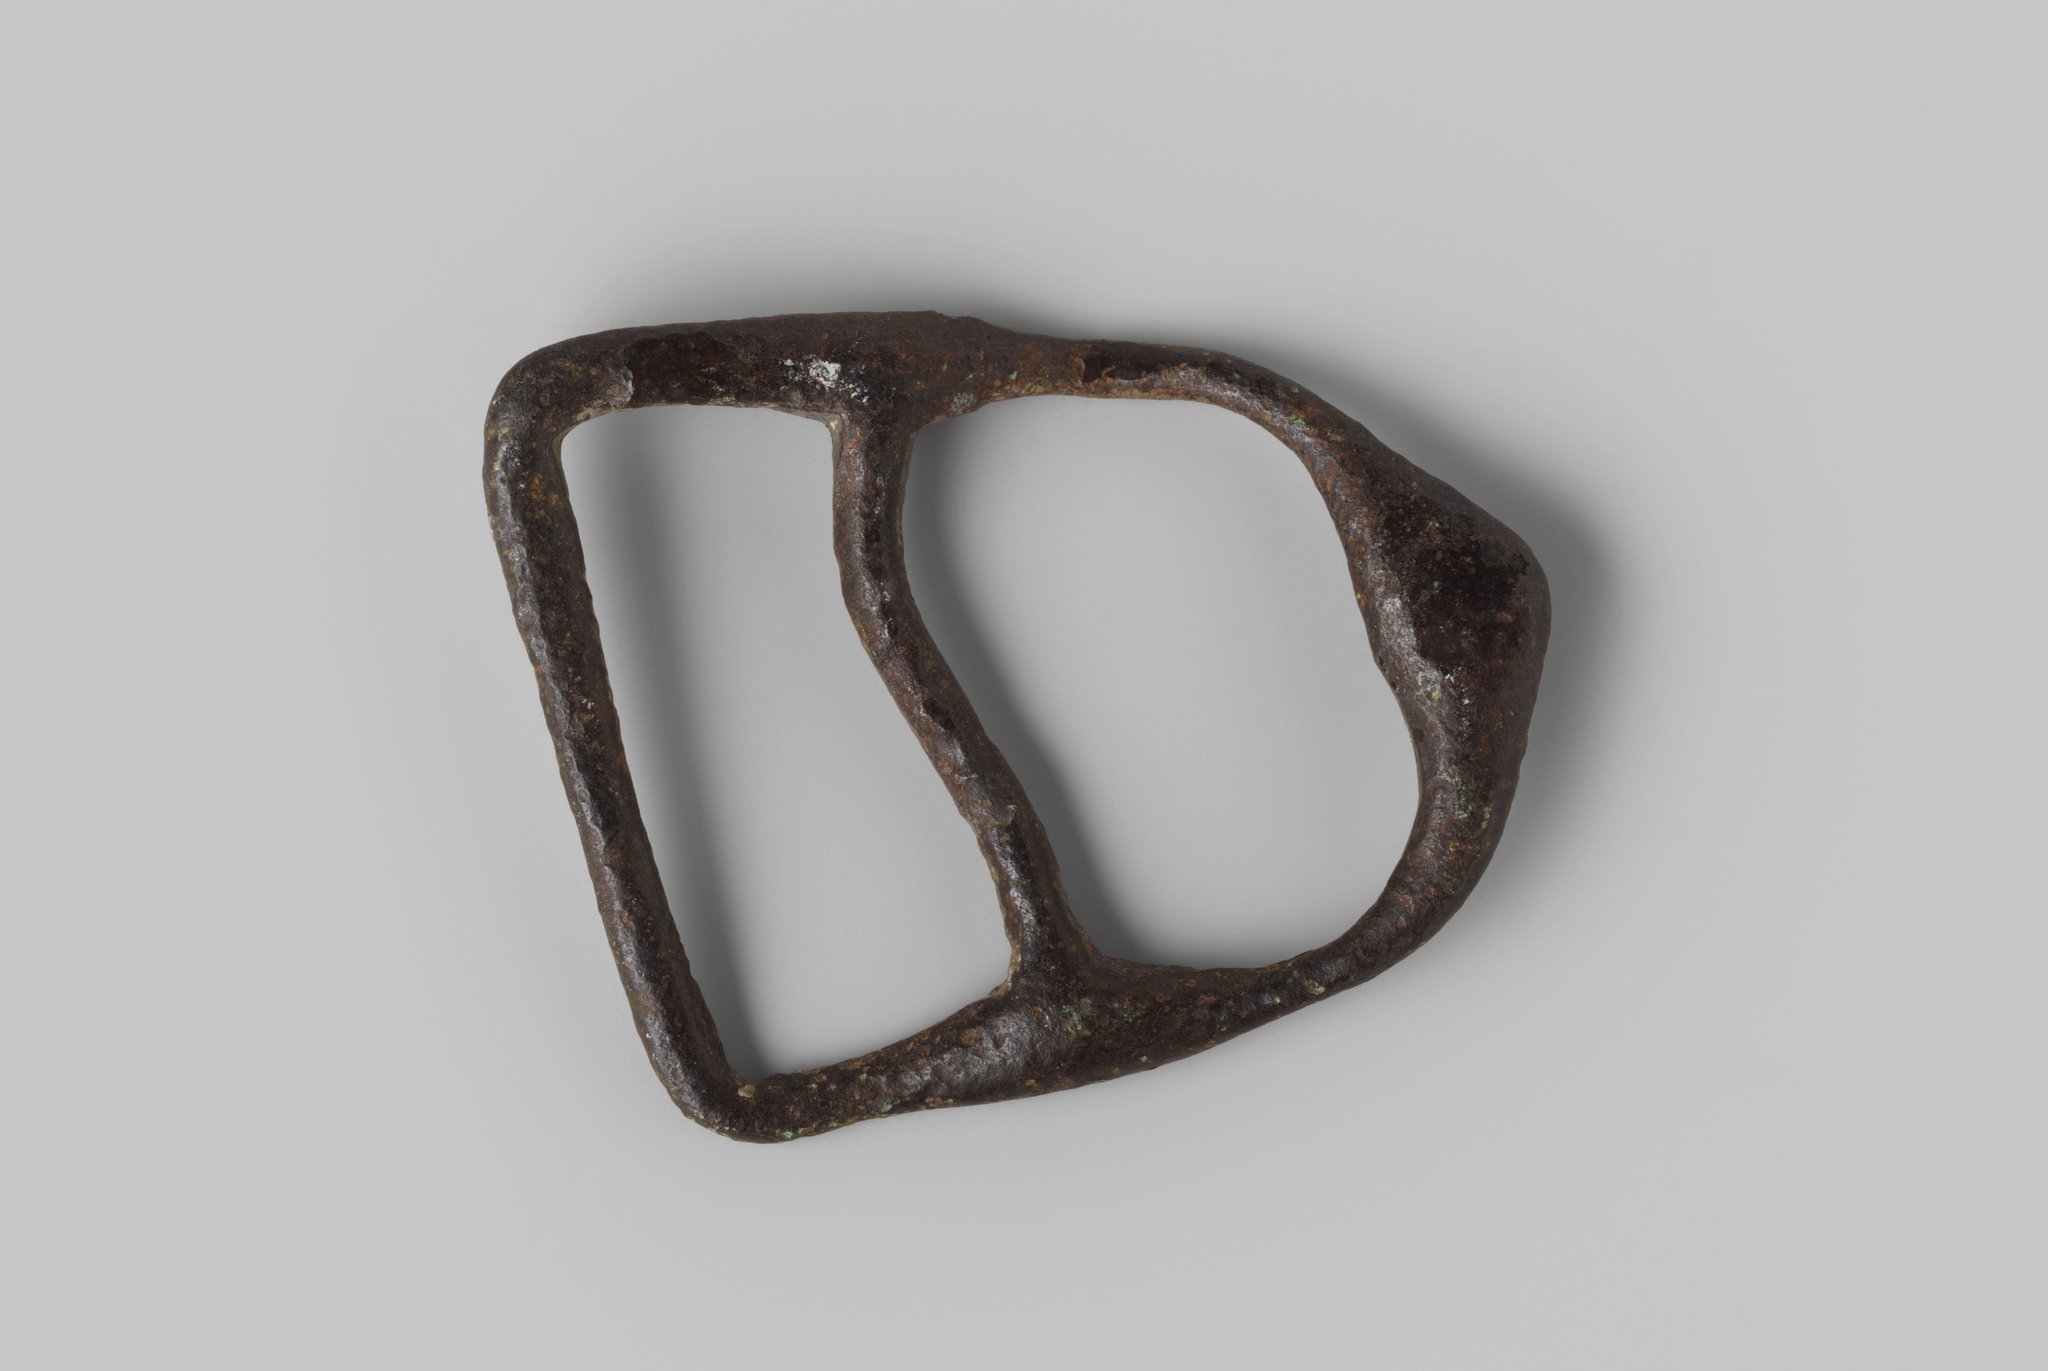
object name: belt buckle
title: Riemgesp uit het wrak van de Oost-Indiëvaarder Hollandia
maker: Anonymous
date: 1700-1743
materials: copper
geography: netherlands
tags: verenigde oostindische compagnie, hollandia (schip), annet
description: D-shaped with pointed side, ring, id. NG 1980-27H384, belt buckle.